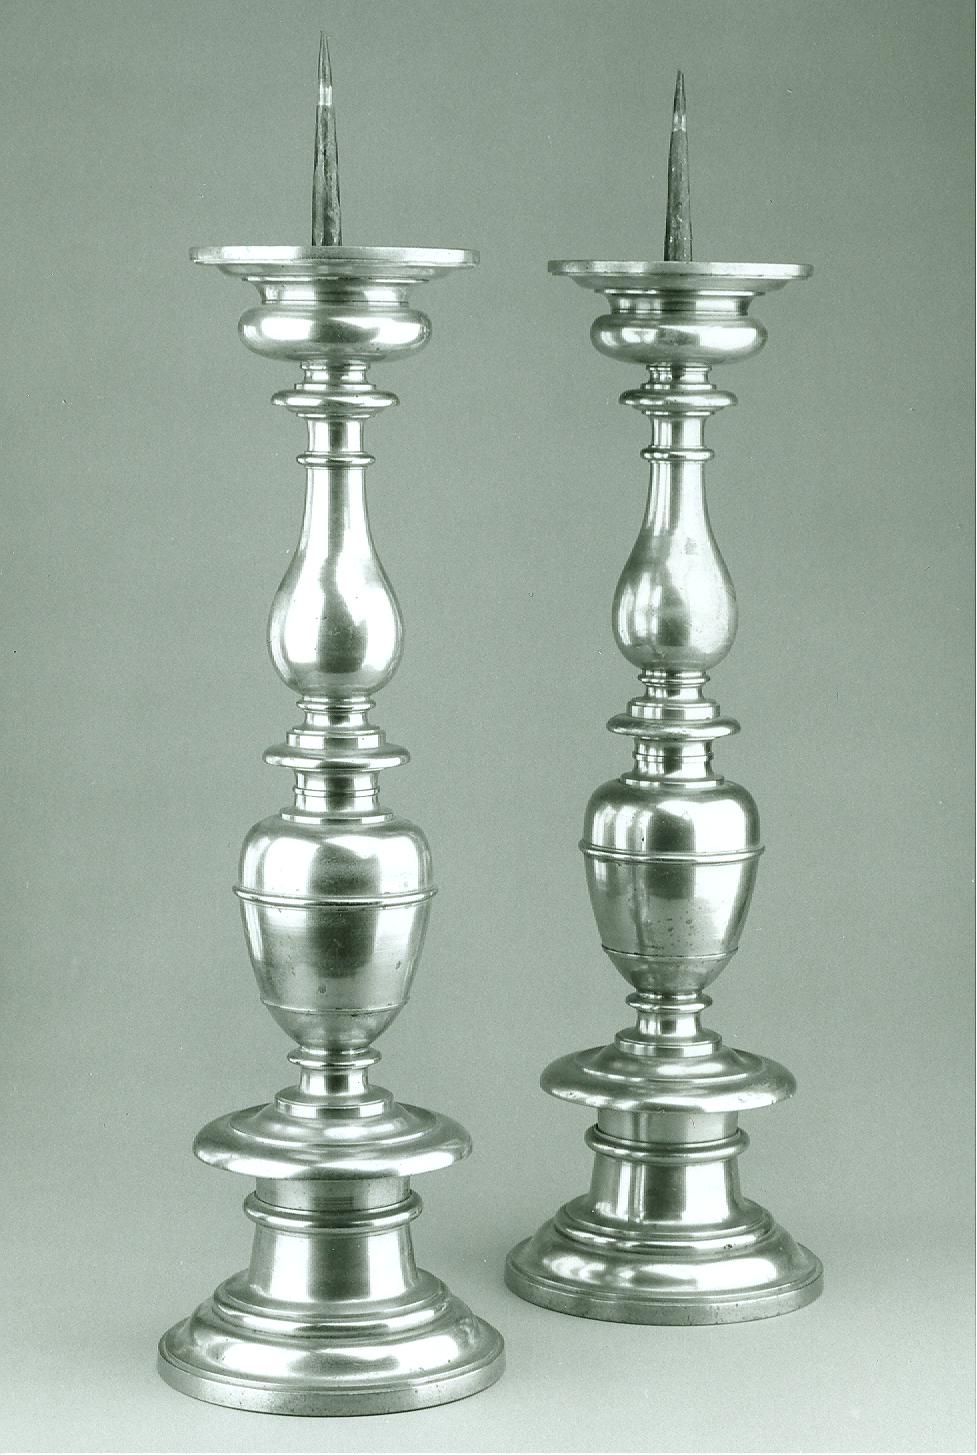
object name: candlestick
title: Altar Candlestick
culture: german or south netherlandish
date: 1601-1700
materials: brass